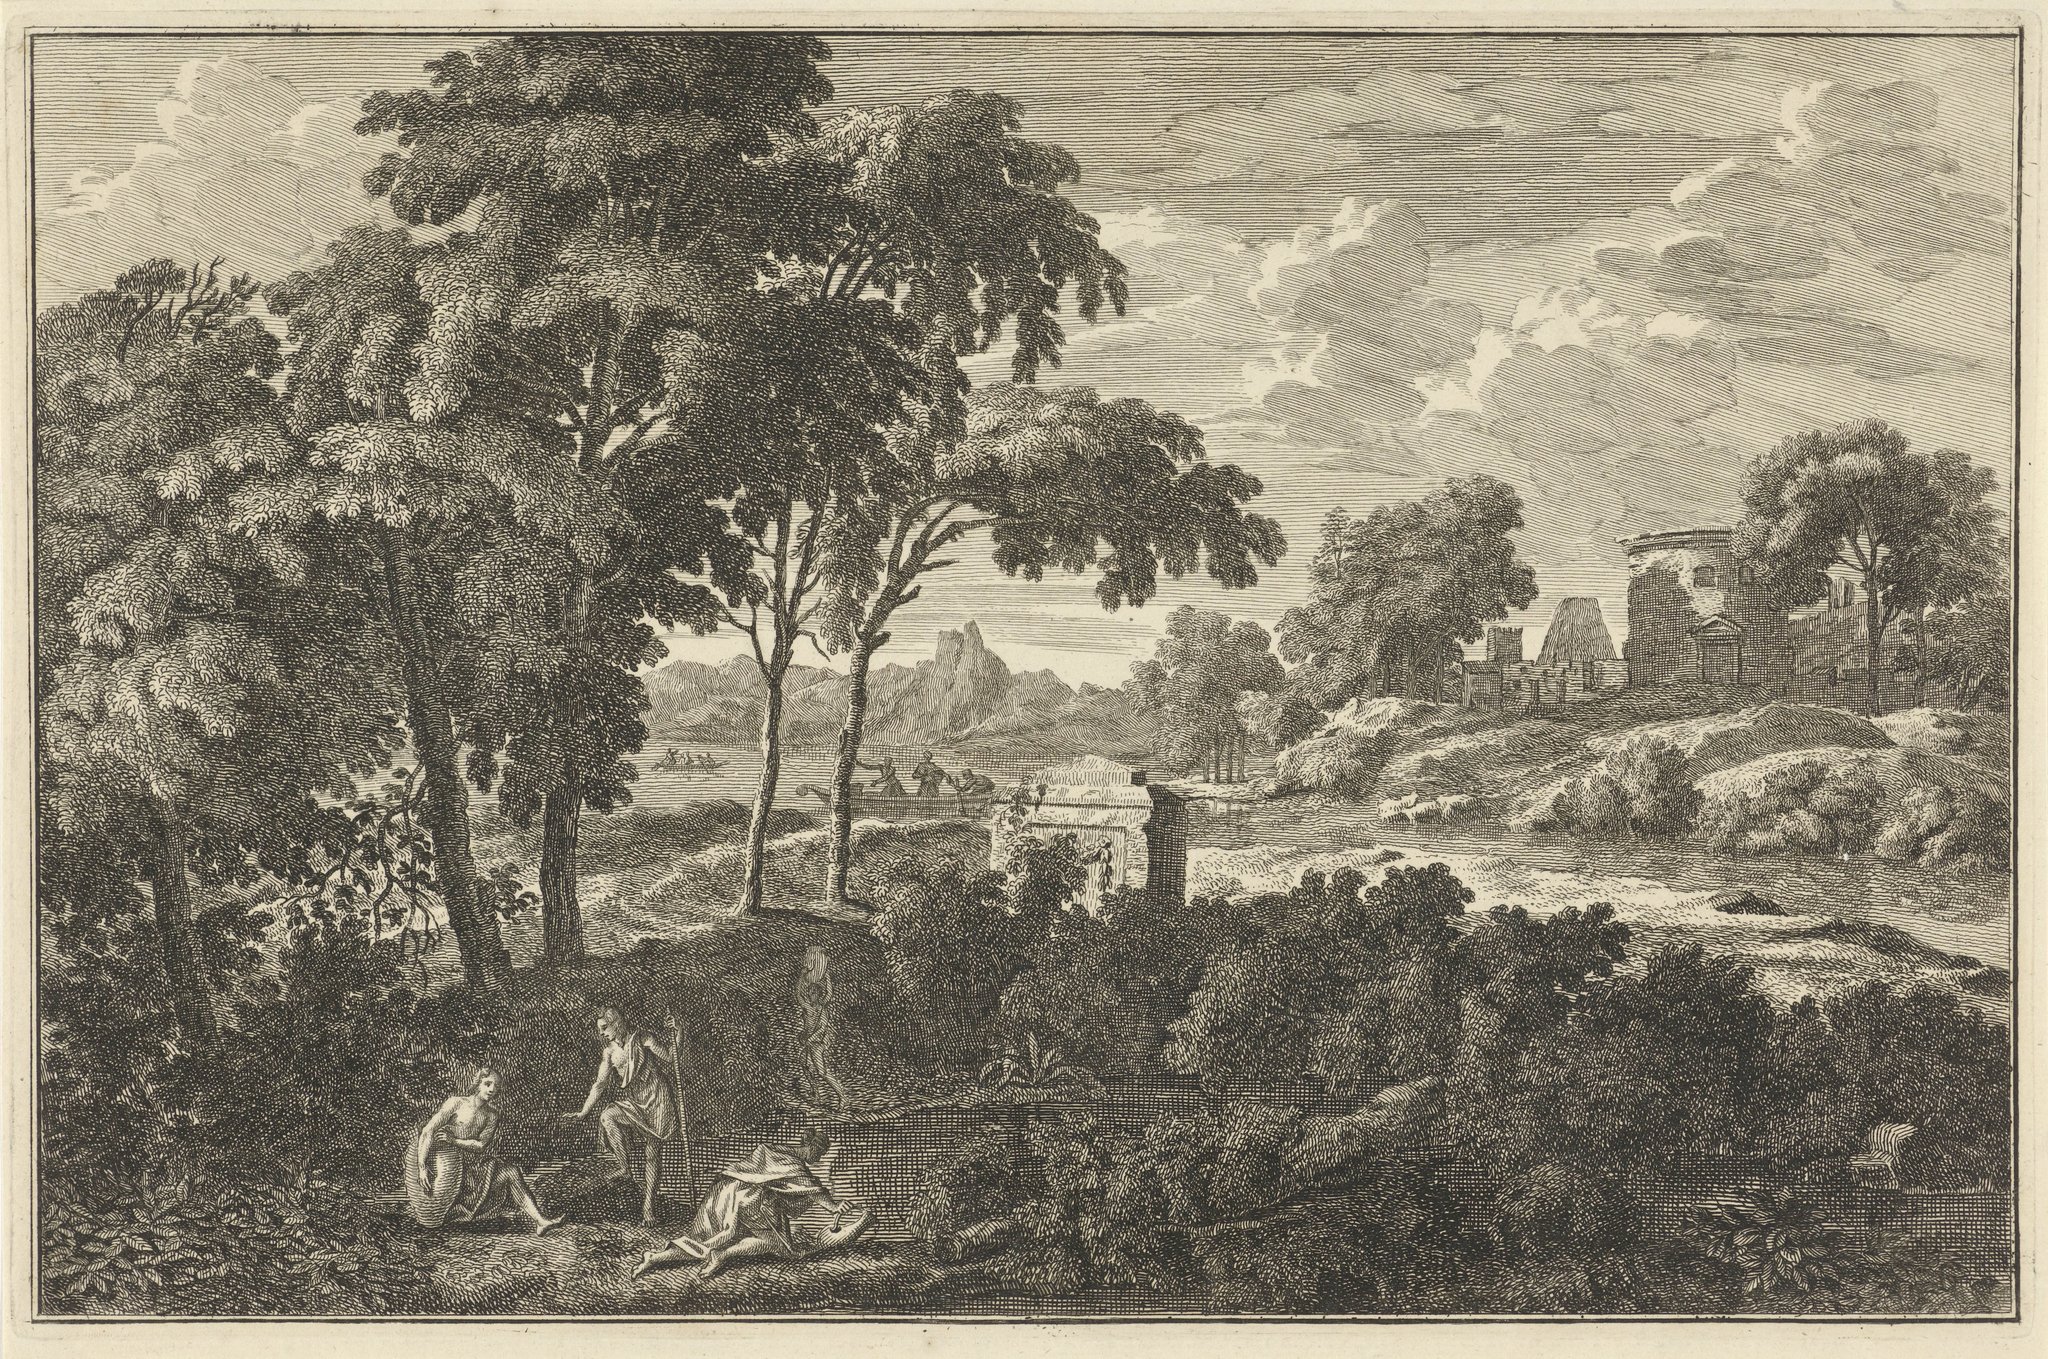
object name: print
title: Arcadisch rivierlandschap met figuren die water halen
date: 1710-1747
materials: paper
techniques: etching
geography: amsterdam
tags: landscapes with waters, waterscapes, seascapes (in the temperate zone), container of ceramics: jar, jug, pot, vase, spring, source of river or stream, fisherman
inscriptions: collector's mark: Lugt 240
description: Arcadisch rivierlandschap met op de voorgrond figuren die water halen, op de achtergrond twee boten met vissers. De prent maakt deel uit van een 40-delige serie prenten met voorstellingen van Italiaanse en Duitse landschappen.